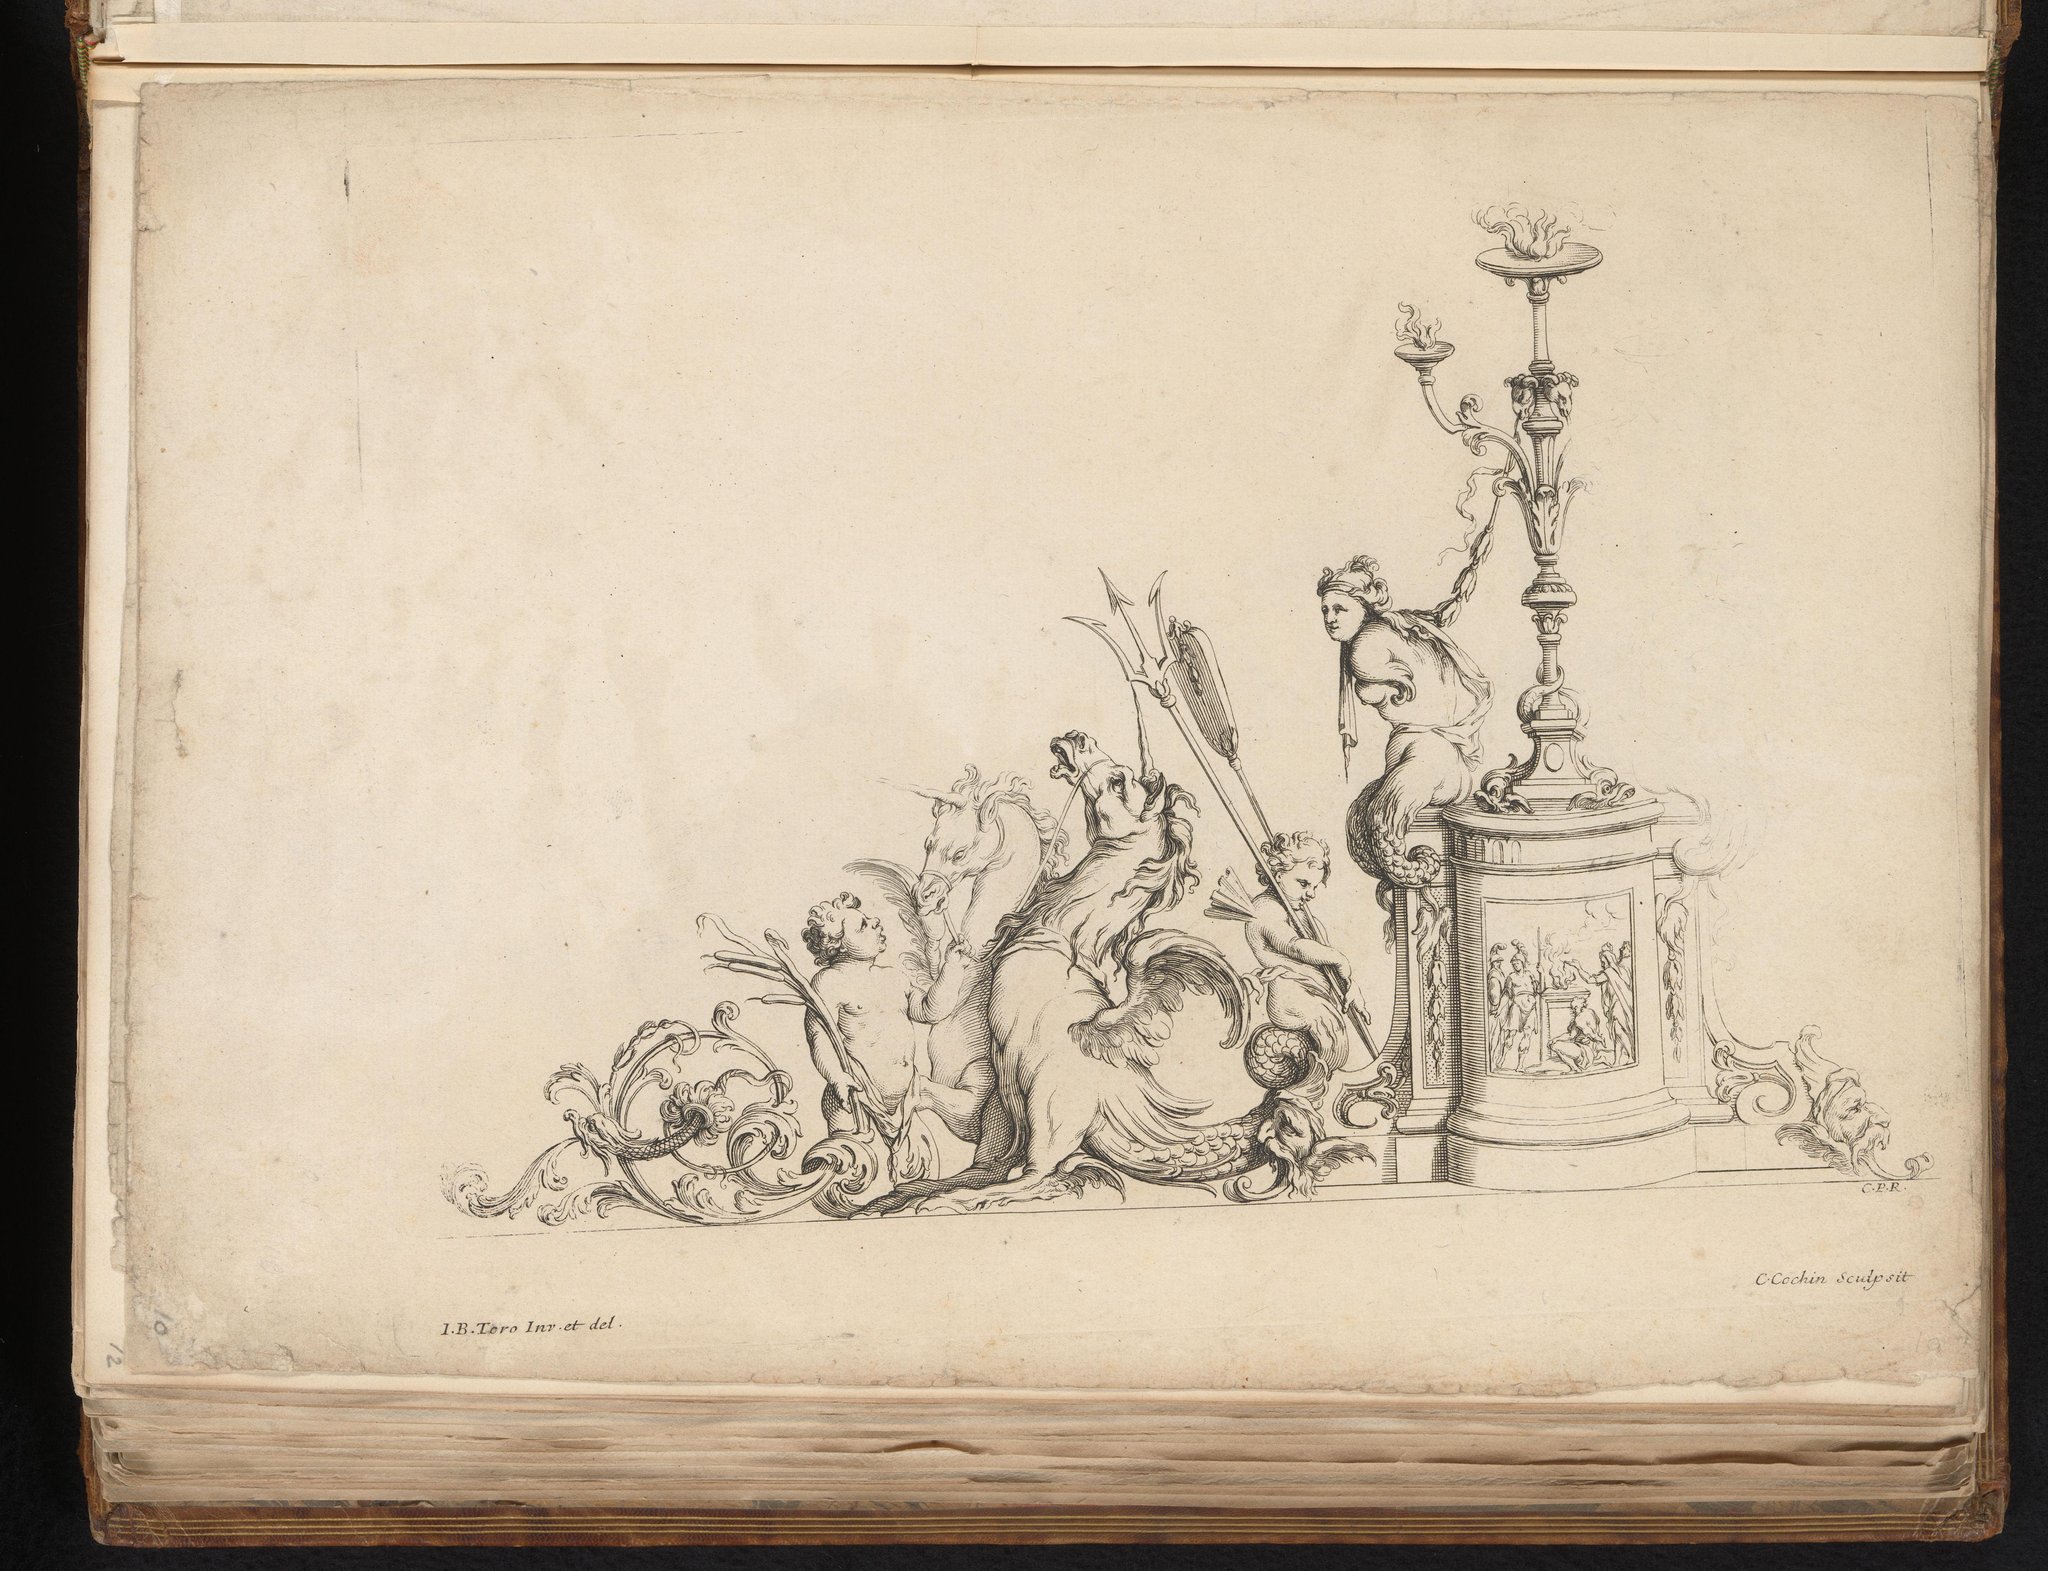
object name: ornament print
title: Arabesken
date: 1716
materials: paper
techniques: engraving, etching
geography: france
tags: sea-horse, hippocamp, 'hippocampus', (horse/fish) (mythological hybrid monster), ornament ~ arabesque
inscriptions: collector's mark: Lugt 2760, collector's mark: Lugt 2228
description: Prent maakt deel uit van een serie van zes prenten.